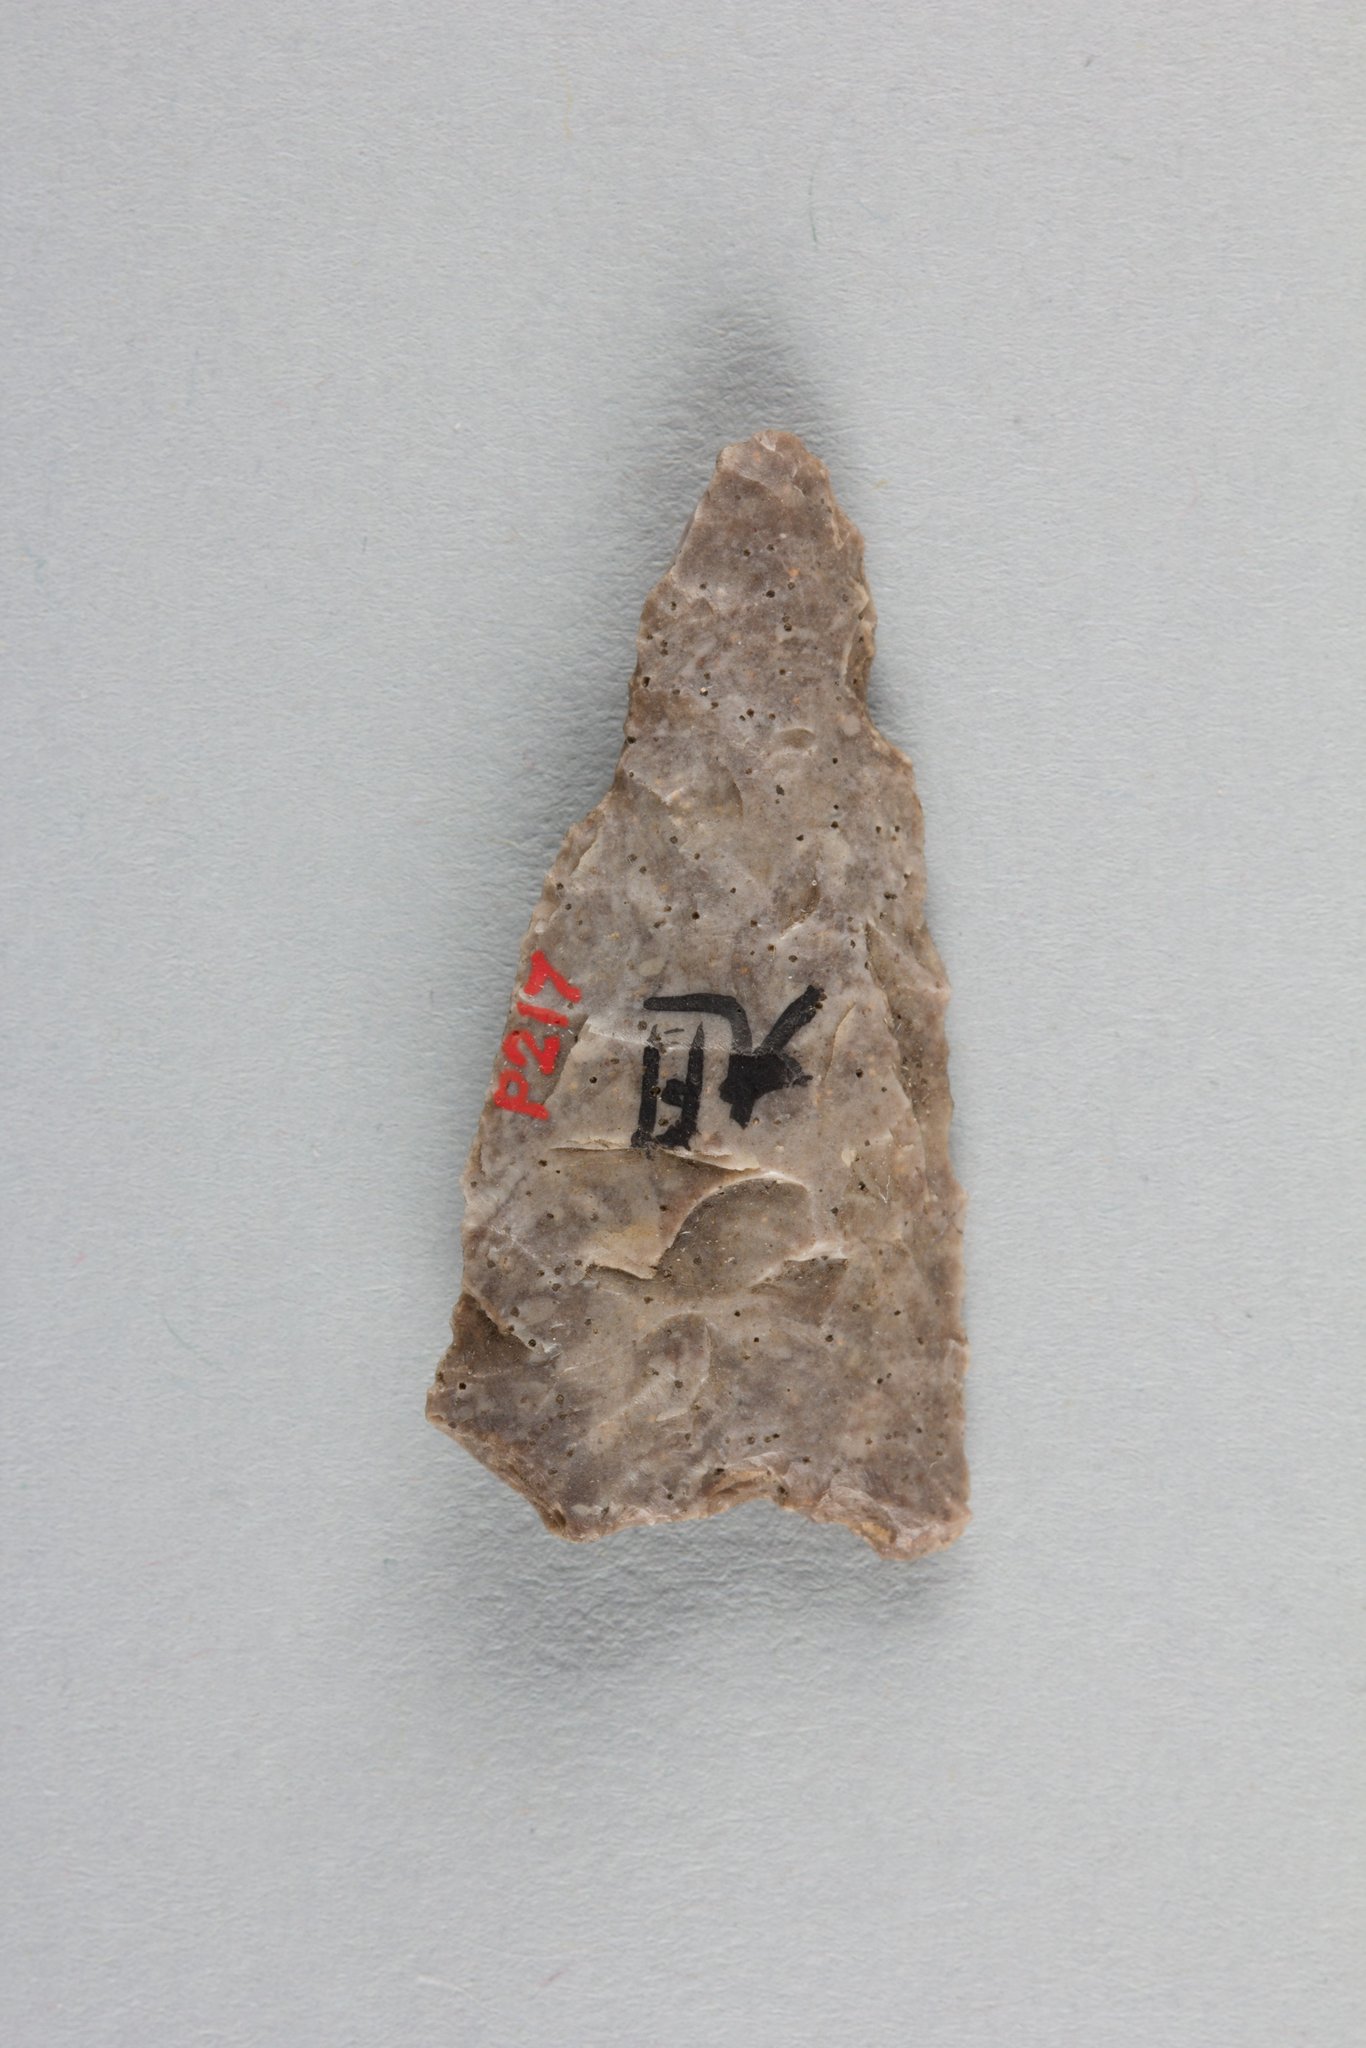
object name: arrowhead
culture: japanese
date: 1500-1000 BCE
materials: stone